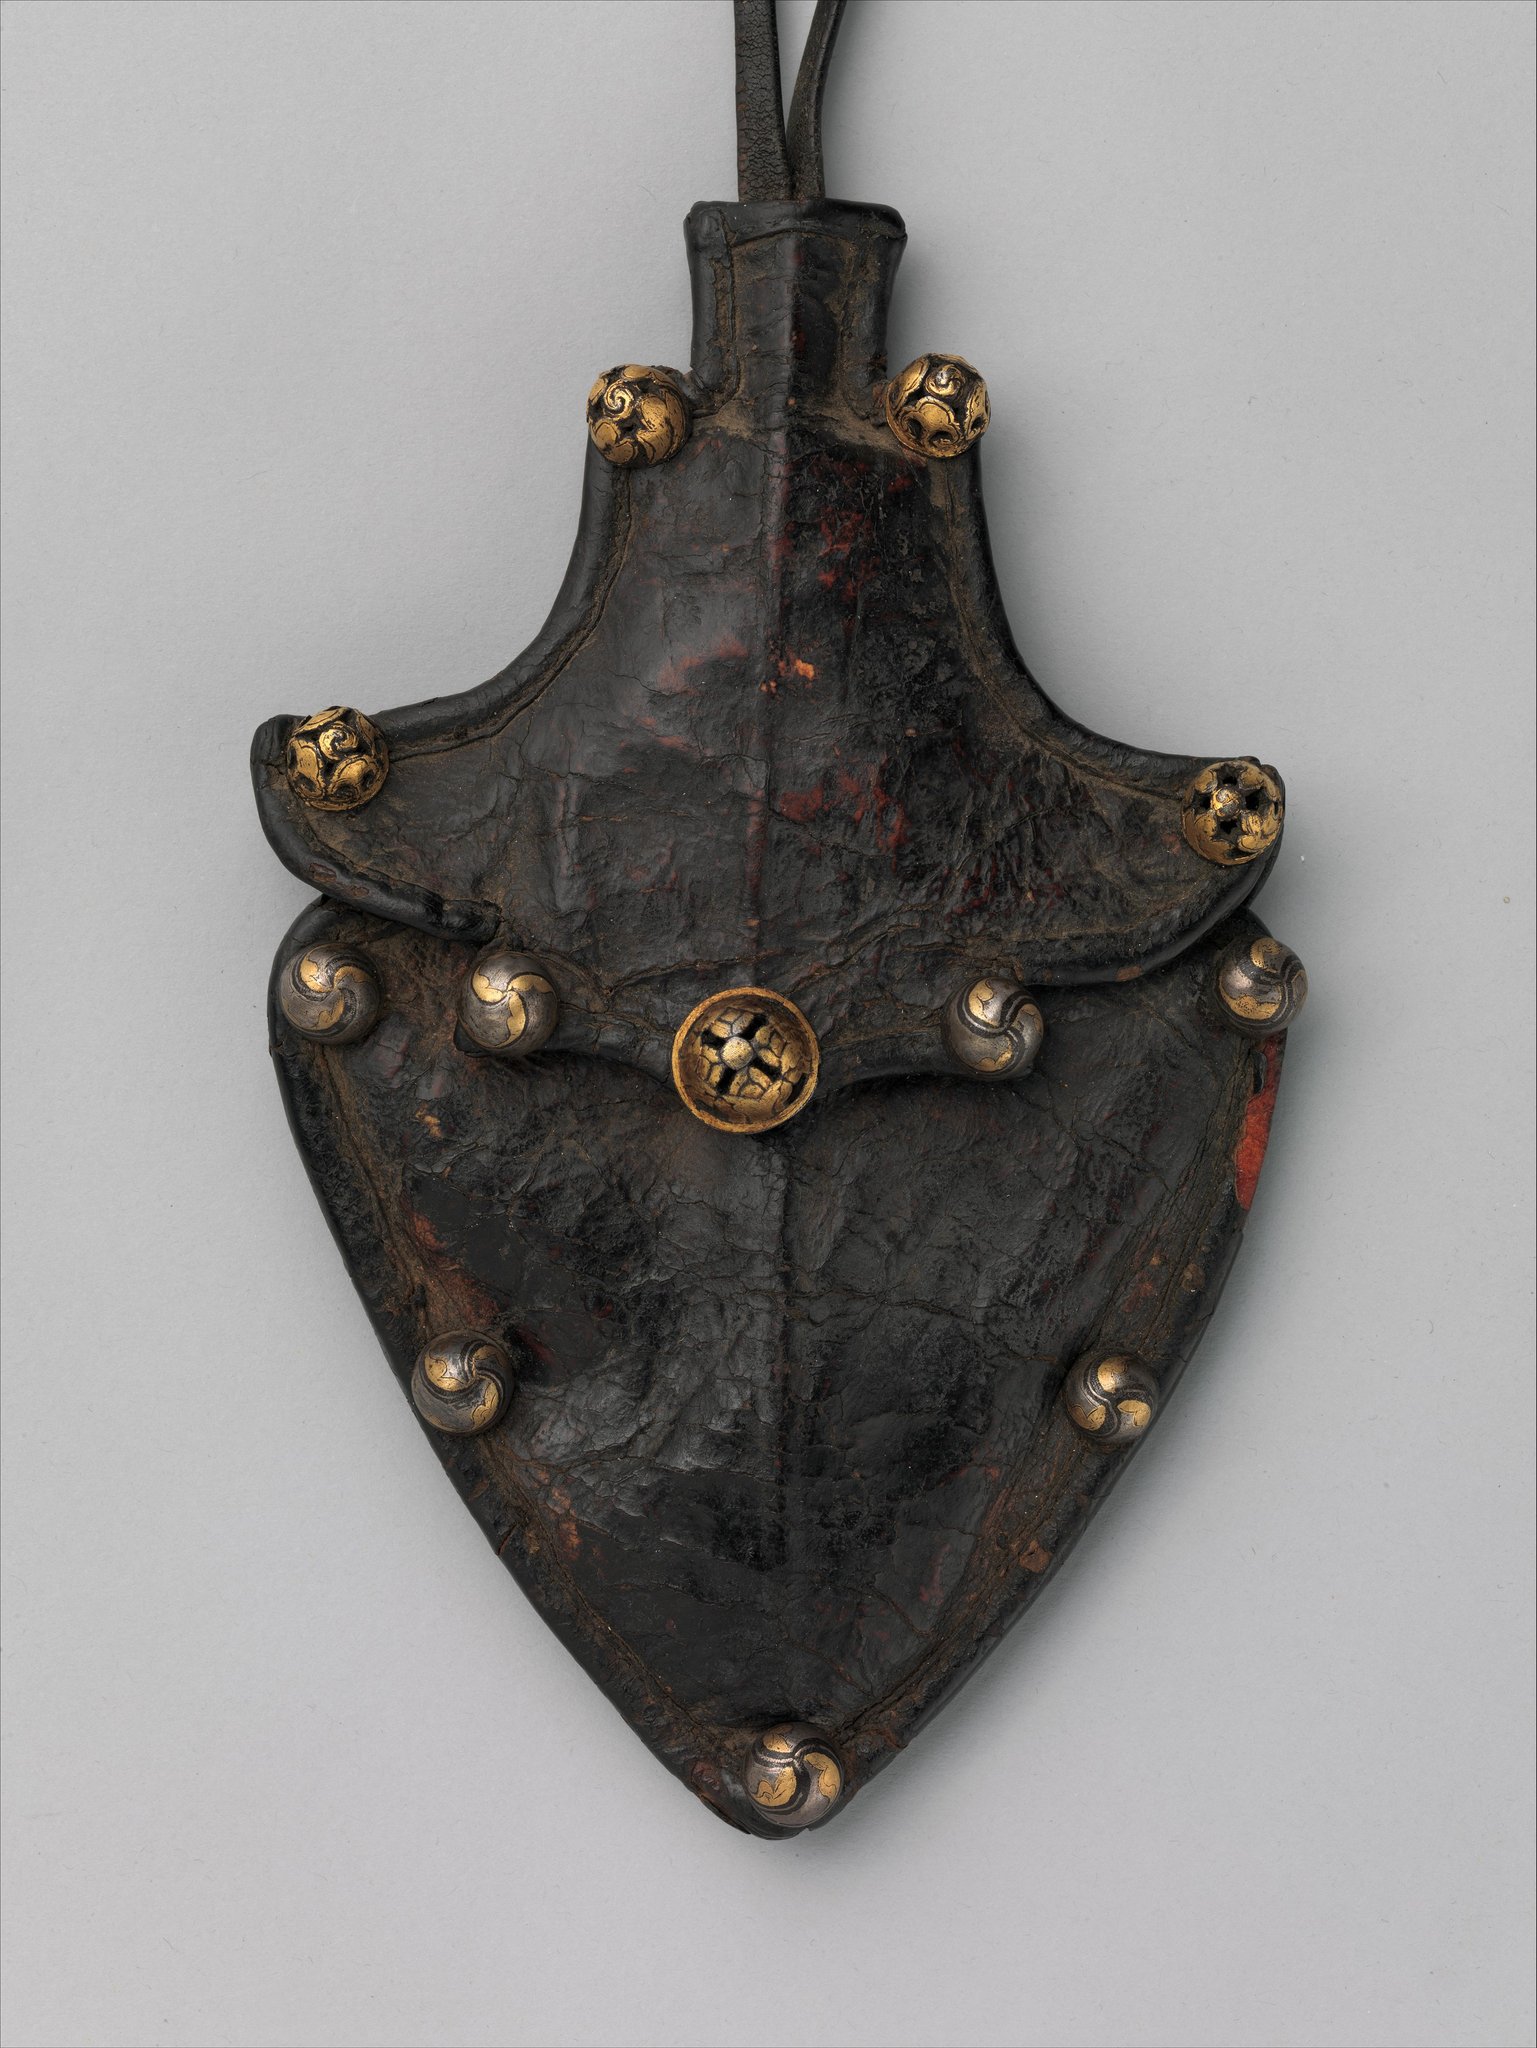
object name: bullet pouch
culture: tibetan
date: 1501-1700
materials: gold, iron, leather, silver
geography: tibet